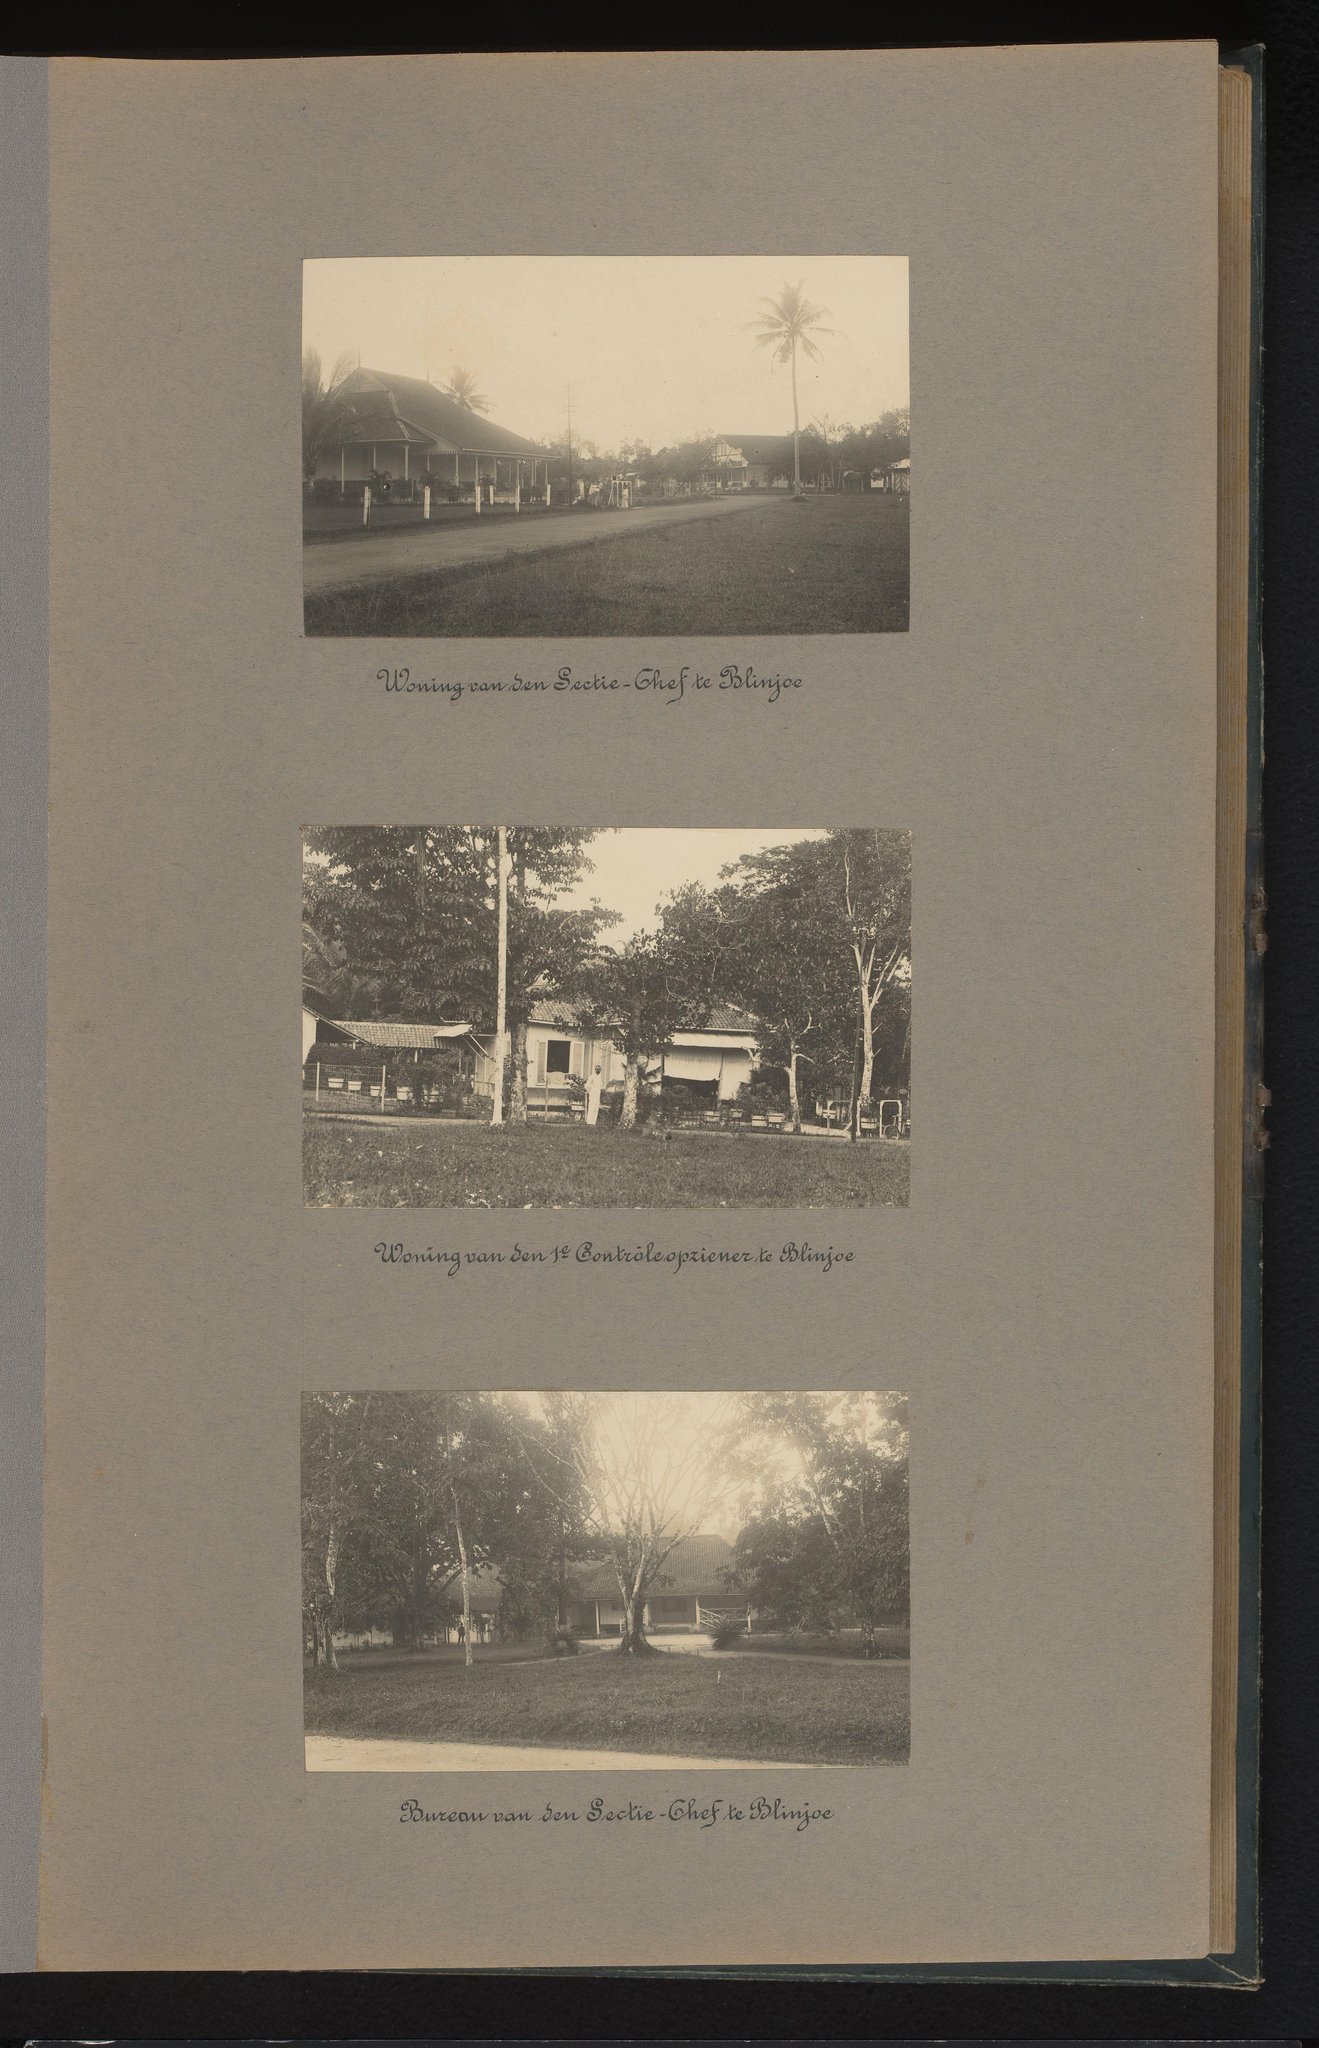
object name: album leaf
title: Woningen van de Banka-tinwinning te Blinjoe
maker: Anonymous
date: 1914-1919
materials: cardboard, photographic support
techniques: gelatin silver print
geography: bangka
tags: robert julius boers, colonial system, mining, villa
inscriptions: inscription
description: Albumblad met drie foto's van woningen van hoger personeel van de Banka-tinwinning te Blinjoe. Onderdeel van het fotoalbum aangeboden aan Robert Julius Boers bij zijn vertrek naar Nederland in 1919 door het personeel van de Banka-tinwinning.